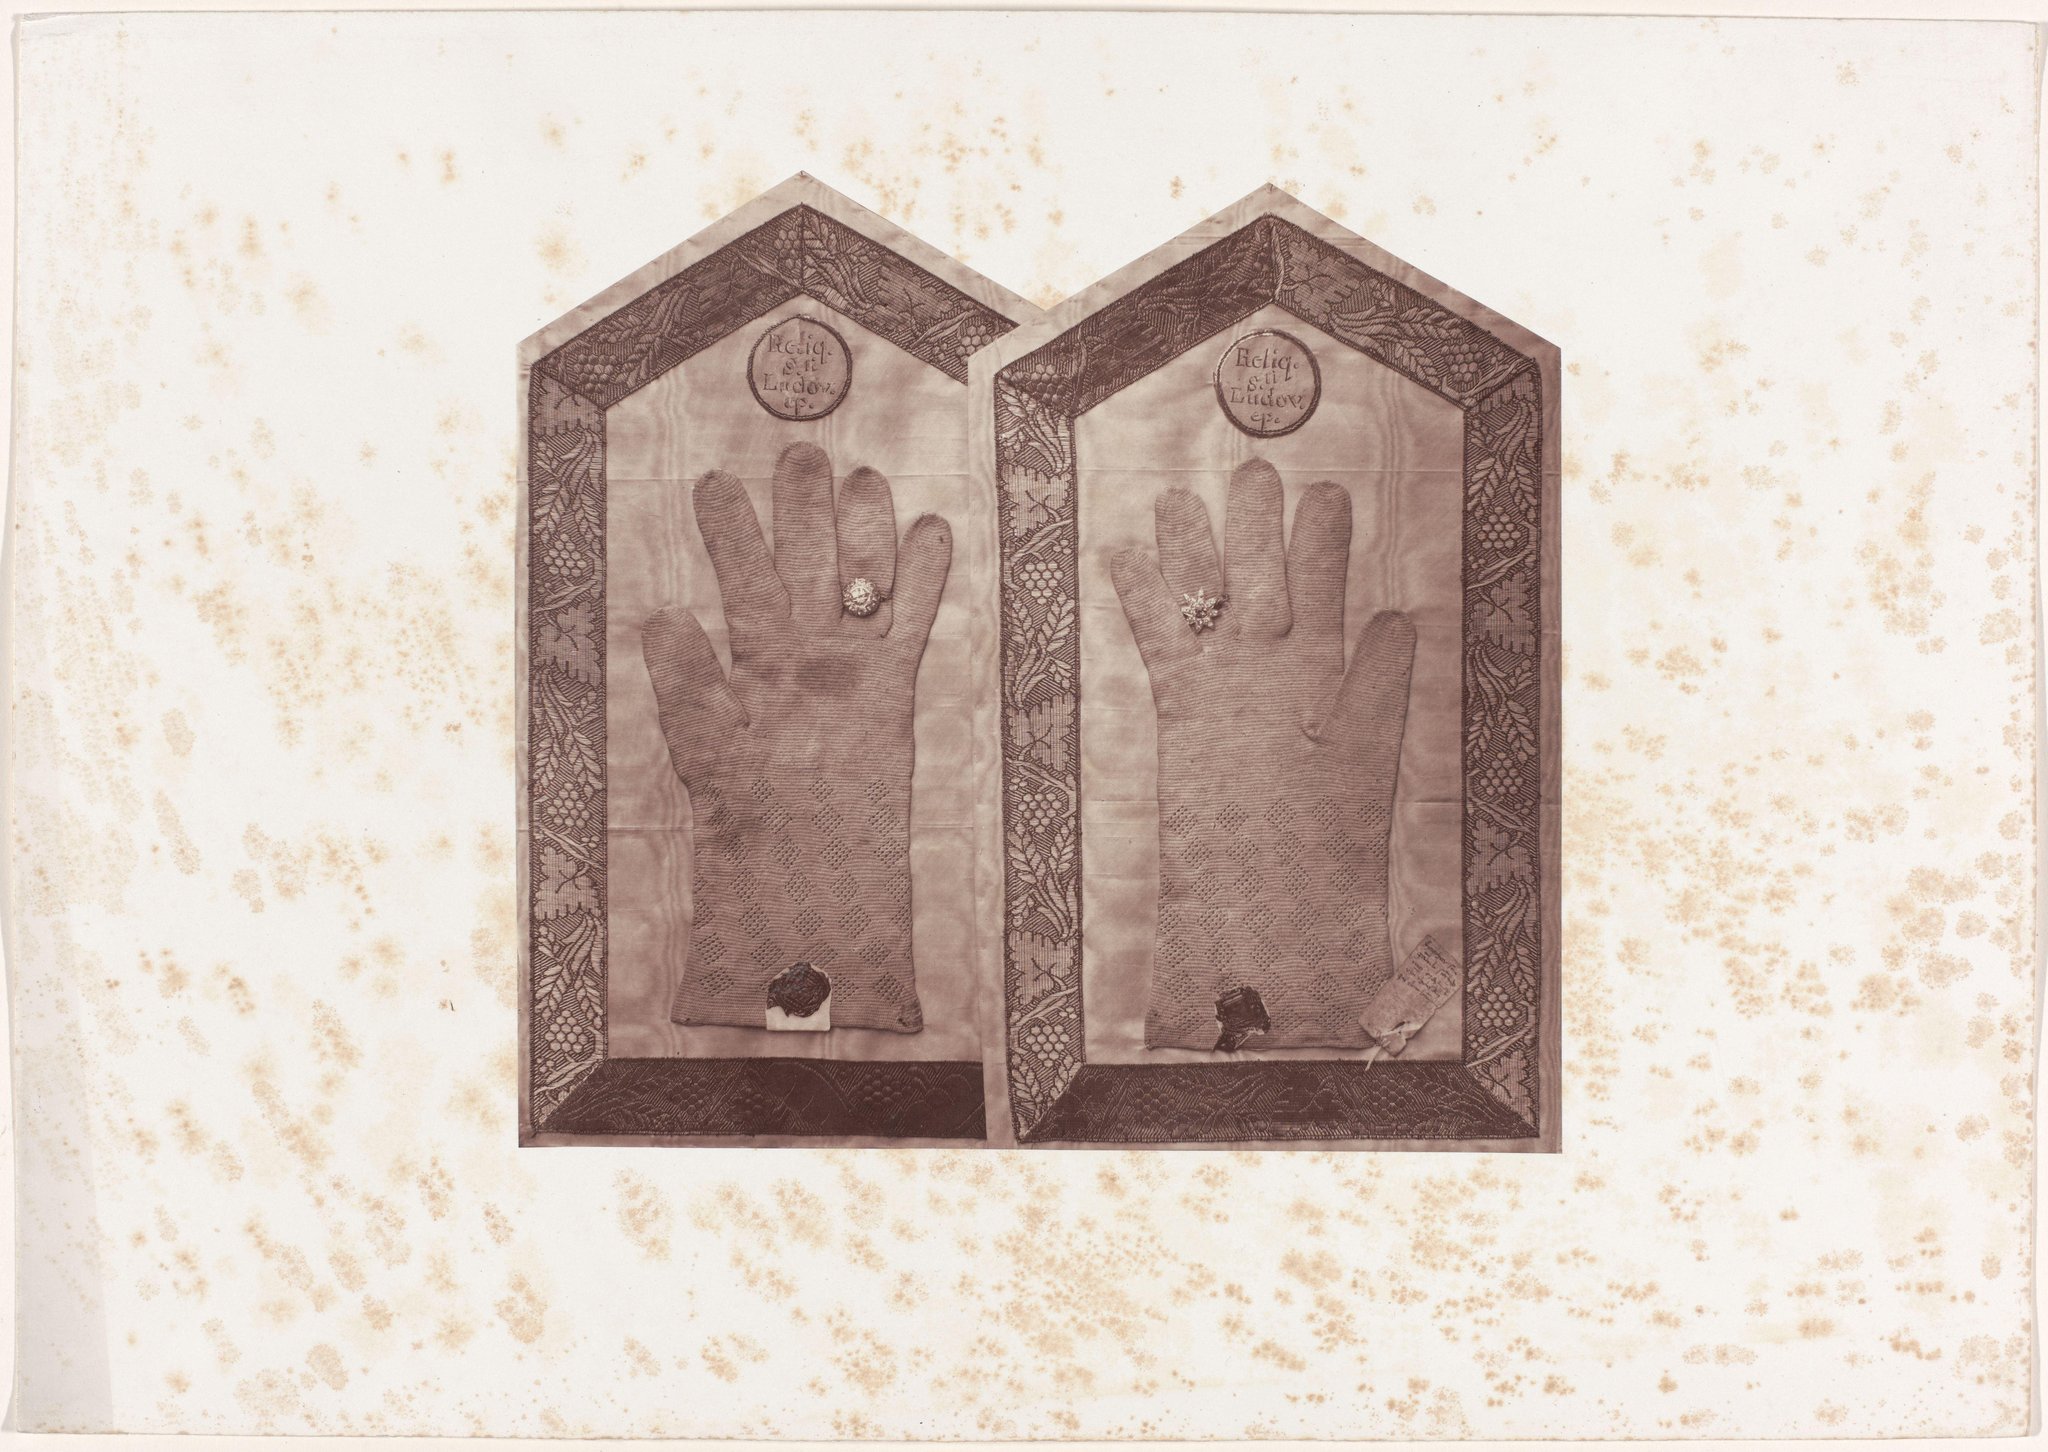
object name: photograph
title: Relieken (twee handschoenen) van heilige Lodewijk van Toulouse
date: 1855-1865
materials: paper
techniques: albumen print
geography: france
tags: gloves, mittens, etc., louis of anjou, son of the king of naples, franciscan friar, and bishop of toulouse; possible attributes: fleur-de-lis on his cope, crown and sceptre